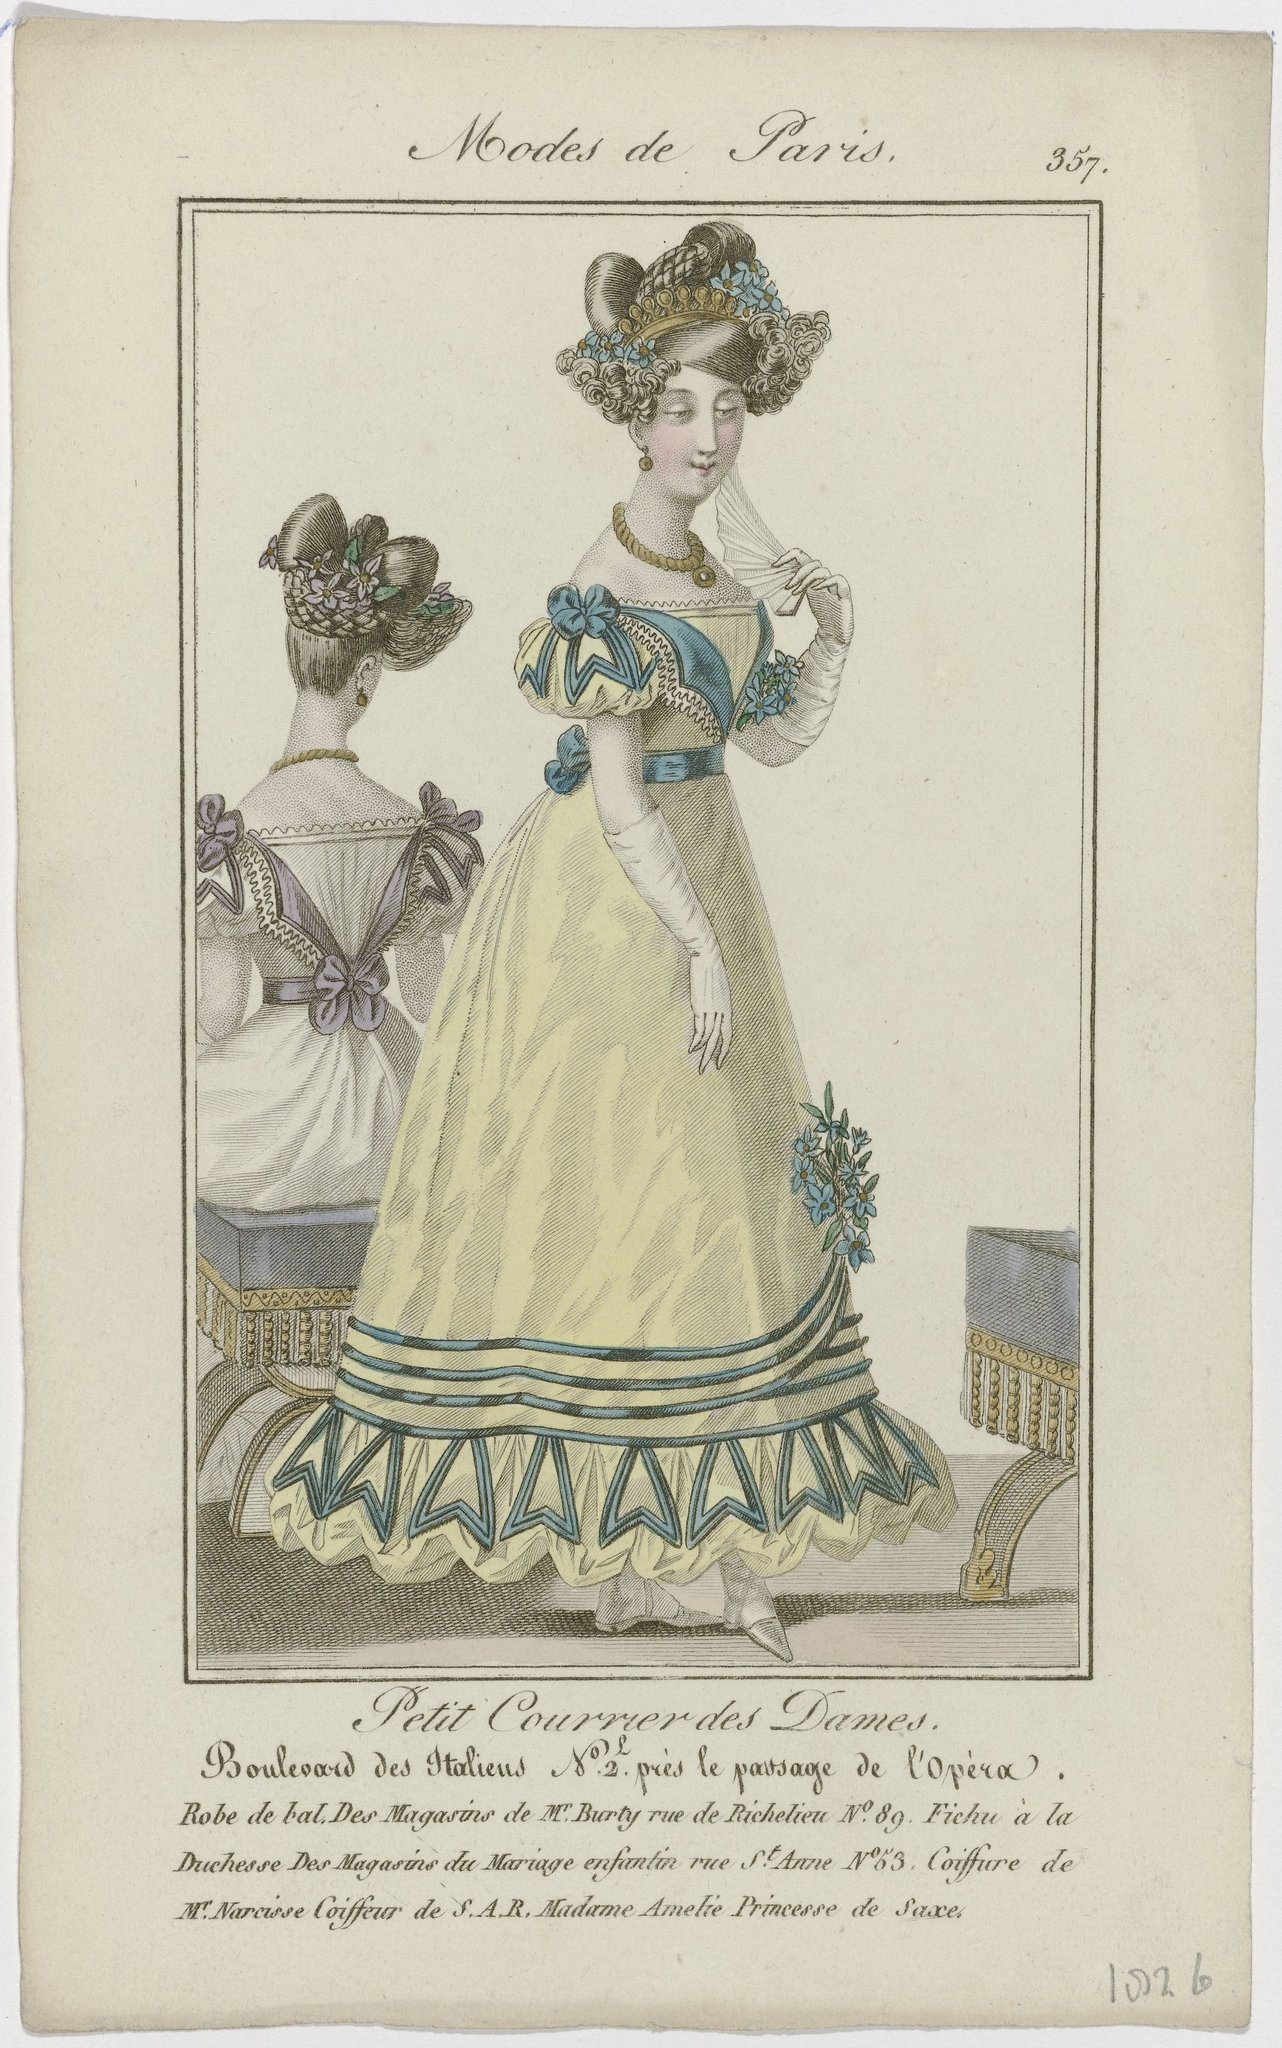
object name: fashion print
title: Petit Courrier des Dames, 1826, No. 357 : Robe de bal (...)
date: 1826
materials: paper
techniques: engraving, hand coloring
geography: paris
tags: corsage (+ women's clothes), ear-rings (+ women's clothes), gloves, mittens (long gloves) (+ women's clothes), dress, gown: ball gown (+ women's clothes), styles of hairdress - aa - ~ women, fashion plates, shoes, sandals (+ women's clothes), fan (+ women's clothes), piece of clothing covering the breast or décolleté (fichu) (+ women's clothes), necklace (+ women's clothes)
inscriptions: title: ‘Modes de Paris.’, address: ‘Boulevard des Italiens No.2 près le passage de l'Opera’, caption: ‘Robe de bal. Des Magasins de Mr. Burty rue de Richelieu No. 89. Fichu à la Duchesse Des Magasins du Mariage enfantin rue St. Anne No. 53. Coiffure de Mr. Narcisse Coiffeur de S.A.R. Madame Amelie Princesse de Saxe.’, title: ‘Petit Courrier des Dames.’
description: Staande vrouw gekleed in een baljapon, van de 'magasins de Mr Burty'. Zij draagt een fichu 'à la Duchesse', van de 'magasins du Mariage enfantin'. 'Coiffure' door Mr. Narcisse, kapper of 'coiffeur' van 'S.A.R. Madame Amelie' prinses van Saksen. Accessoires: diadeem, oorbel in het rechteroor, collier met ronde hanger, waaier, bloemcorsage, lange handschoenen, platte schoenen met punitge neuzen en gekruiste banden. Links een zittende vrouw, op de rug gezien, gekleed in eenzelfde japon. Prent uit het modetijdschrift Petit Courrier des Dames (1821-1868).